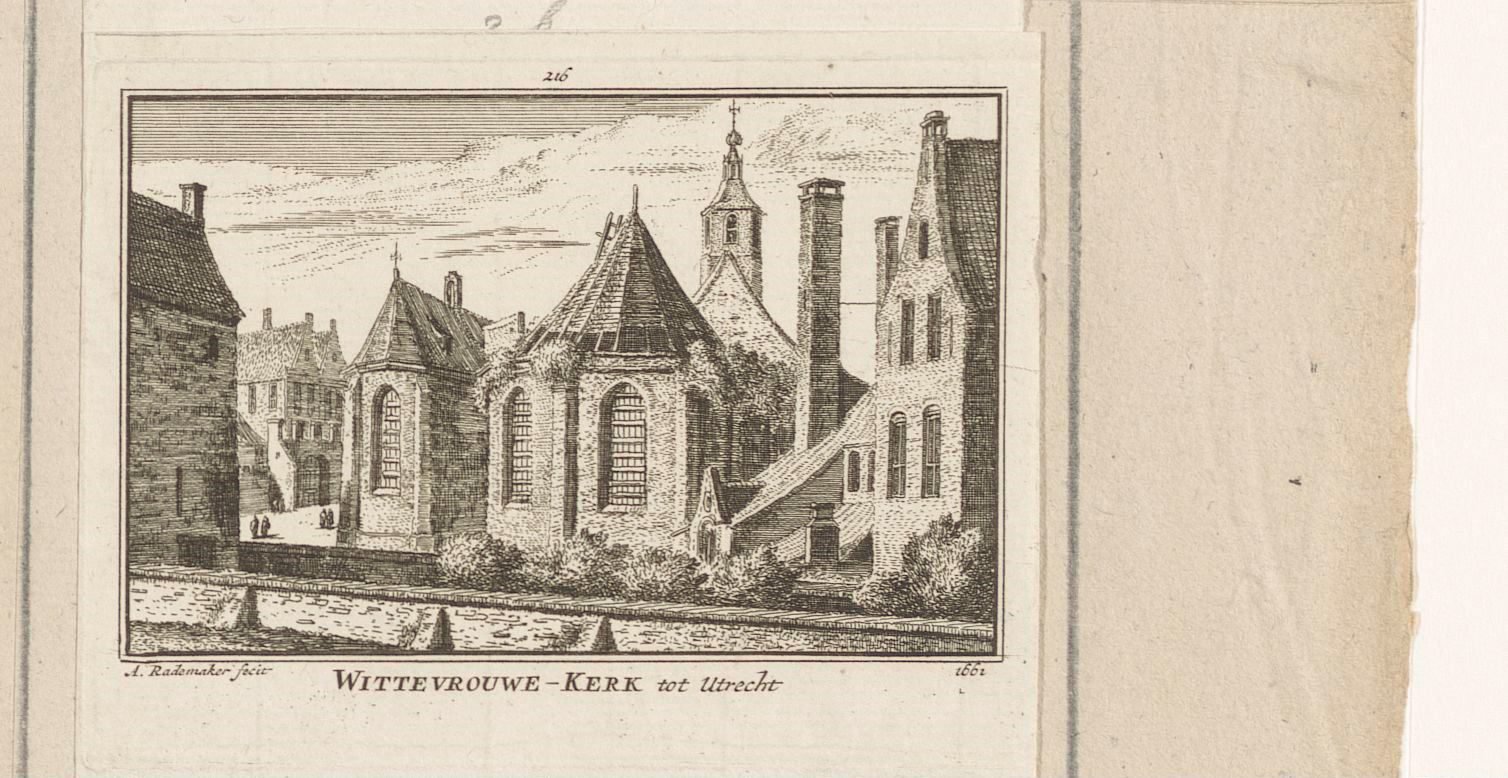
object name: print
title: Wittevrouwe-kerk tot Utrecht 1661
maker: abraham rademaker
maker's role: draughtsman, print maker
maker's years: 1676-1735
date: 1725-1803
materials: paper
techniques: engraving, etching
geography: amsterdam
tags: church (exterior), cloisters ~ monastery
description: Prent ook gebruikt in: Rademaker, Abraham. Kabinet van Nederlandsche outheden en gezichten: vervat in 300 konstplaaten (…). 2 delen. Amsterdam: Willem Barents, 1725, dl. 2, ill. 216. Na 1725 is deze prent nog in verschillende heruitgaven verschenen, uitgegeven in 1727-1733, 1770-1771 en 1792-1803. Uit welke uitgave het huidige exemplaar precies komt is niet na te gaan.